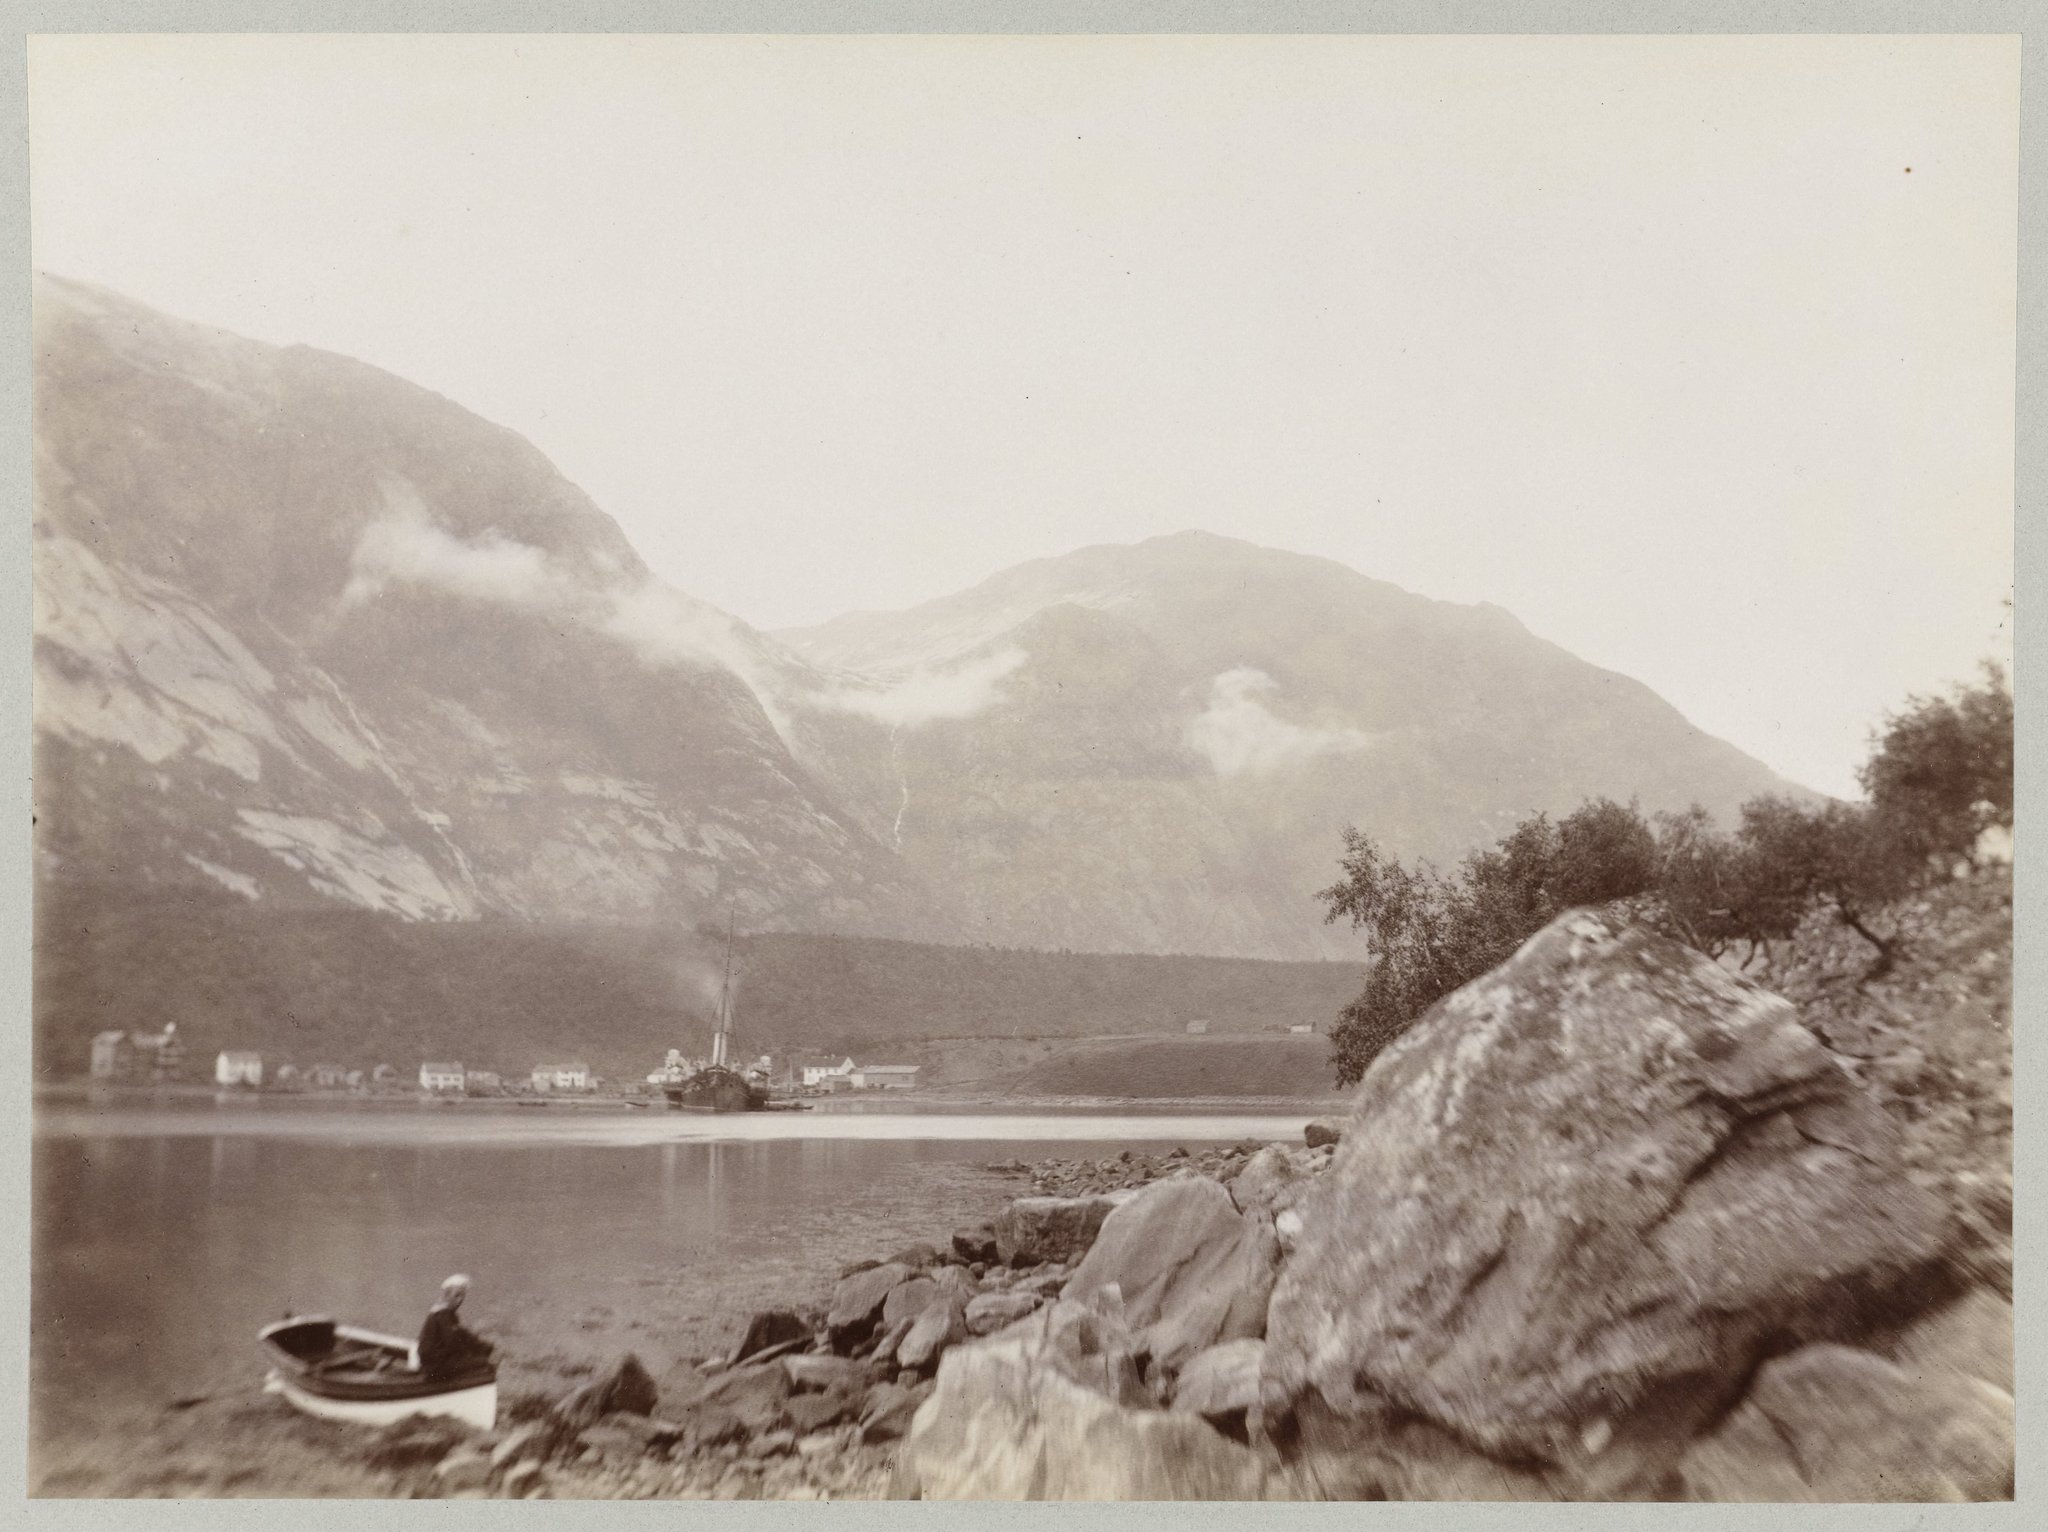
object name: photograph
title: Vik im Eidfjord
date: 1807-1889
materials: cardboard, paper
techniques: albumen print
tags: norway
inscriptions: number: ‘7’